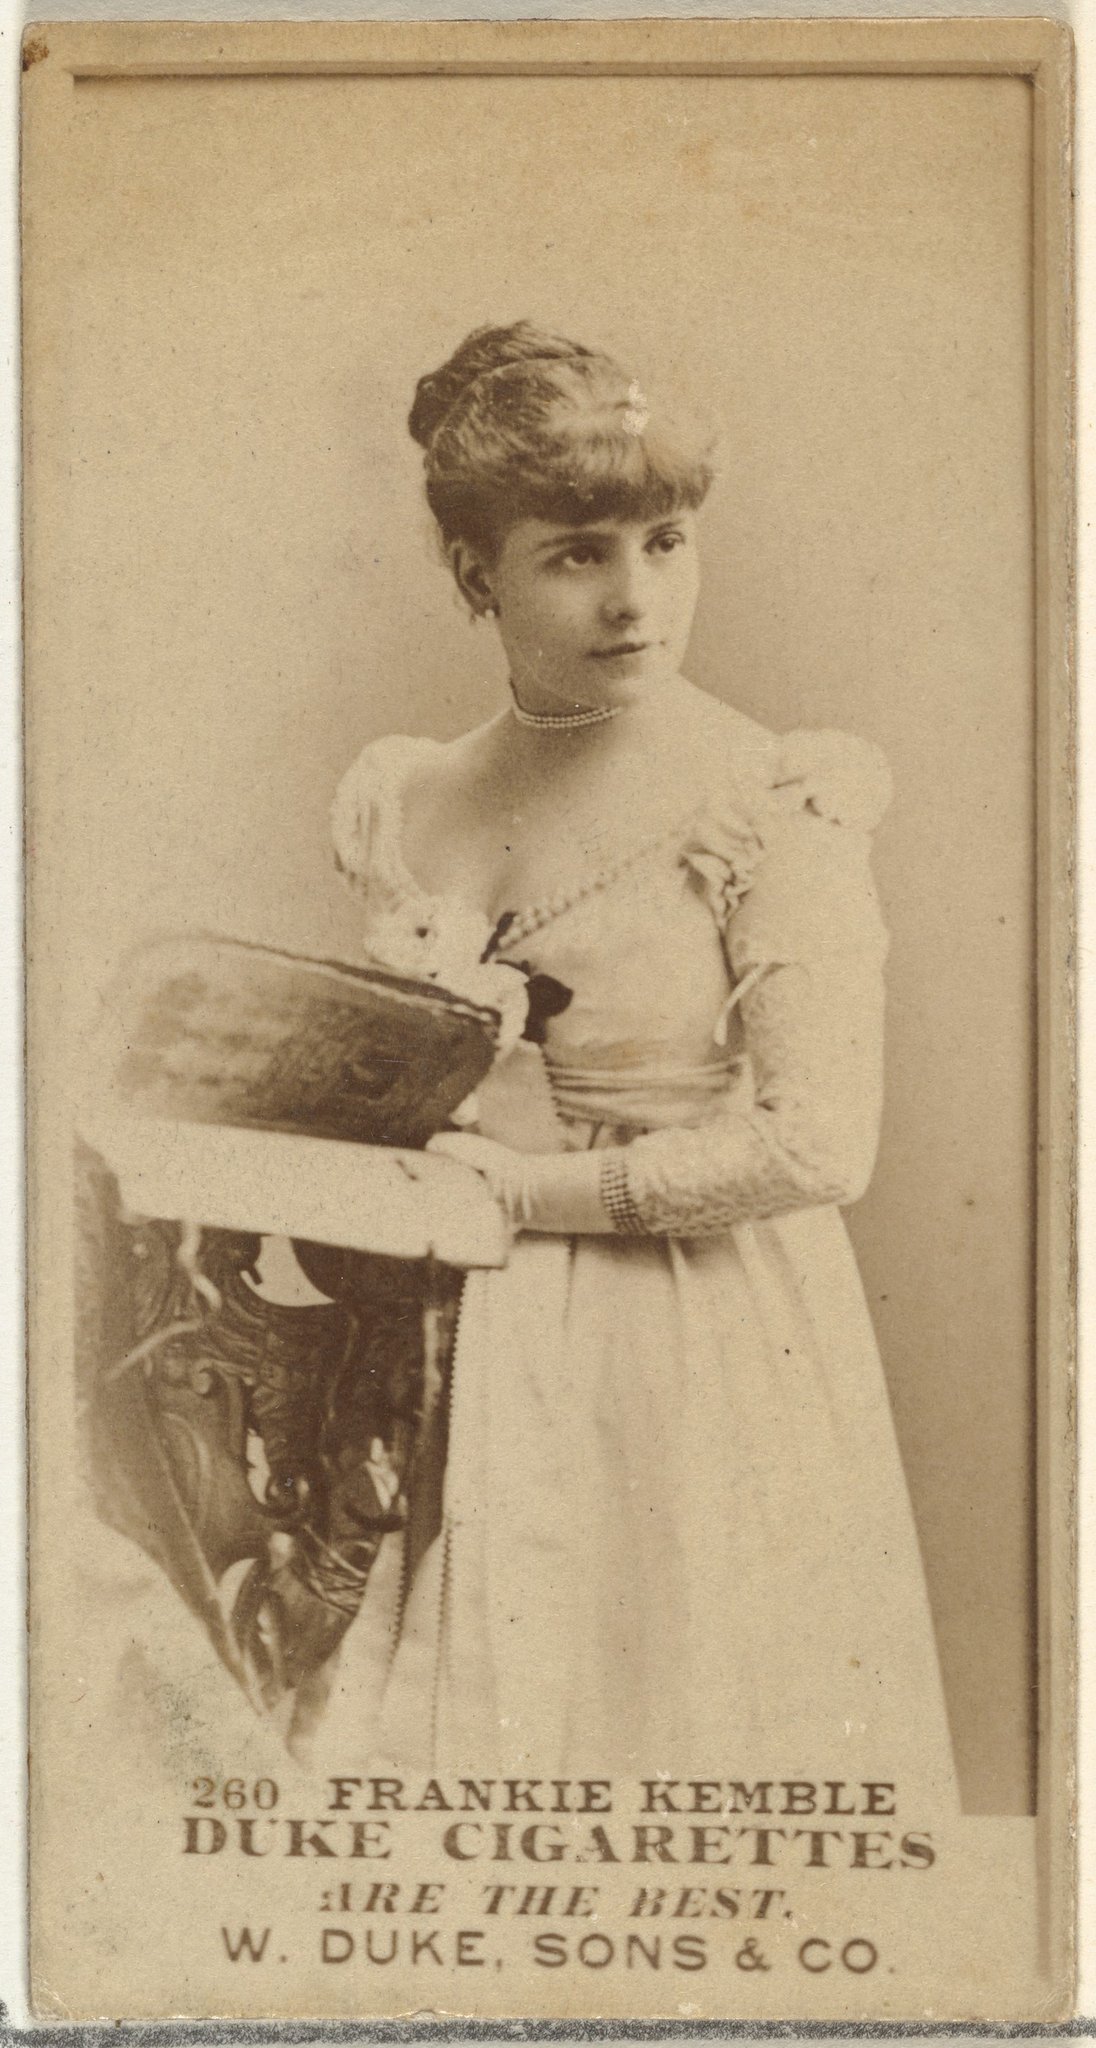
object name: photograph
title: Card Number 260, Frankie Kemble, from the Actors and Actresses series (N145-7) issued by Duke Sons & Co. to promote Duke Cigarettes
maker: w. duke, sons & co.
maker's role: publisher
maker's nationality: american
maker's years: 1870-1920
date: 1880-1889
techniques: albumen silver print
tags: portraits,women,actresses